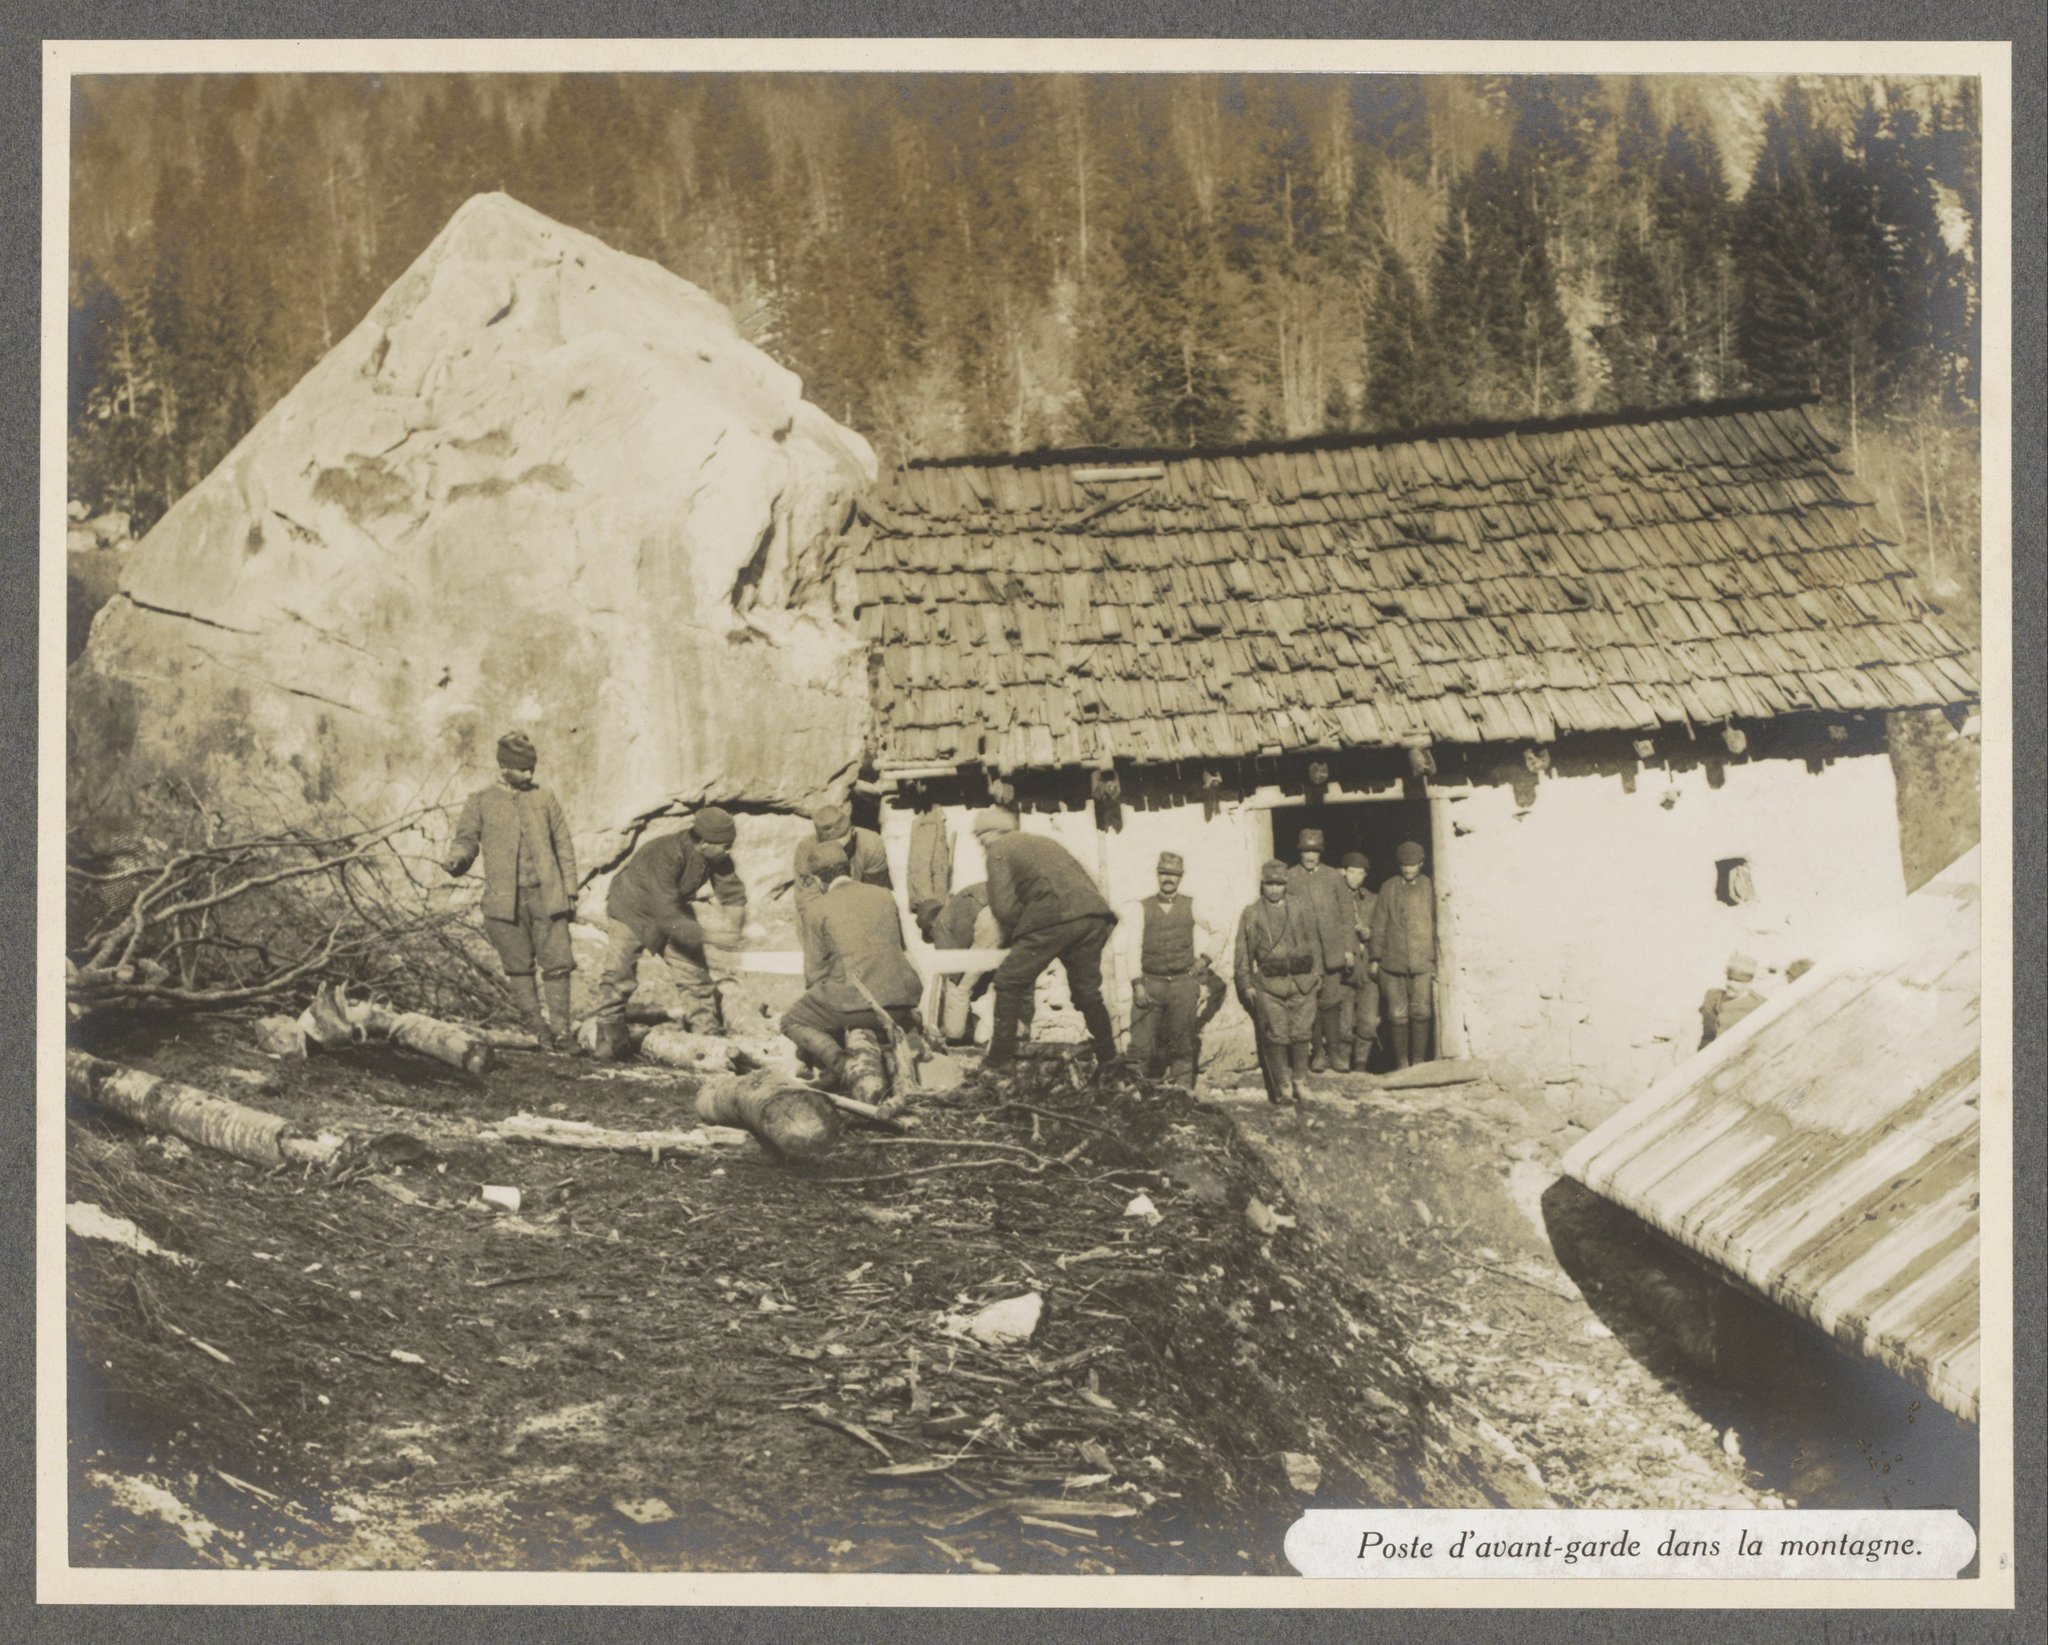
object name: photograph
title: Poste d'avant-garde dans la montagne.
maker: henri de rothschild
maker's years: 1872-1947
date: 1916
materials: photographic support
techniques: gelatin silver print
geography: dolomites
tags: barn, war (+ land forces)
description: Onderdeel van Fotoalbum Medische missie H. de Rothschild naar het Italiaanse front 1916.